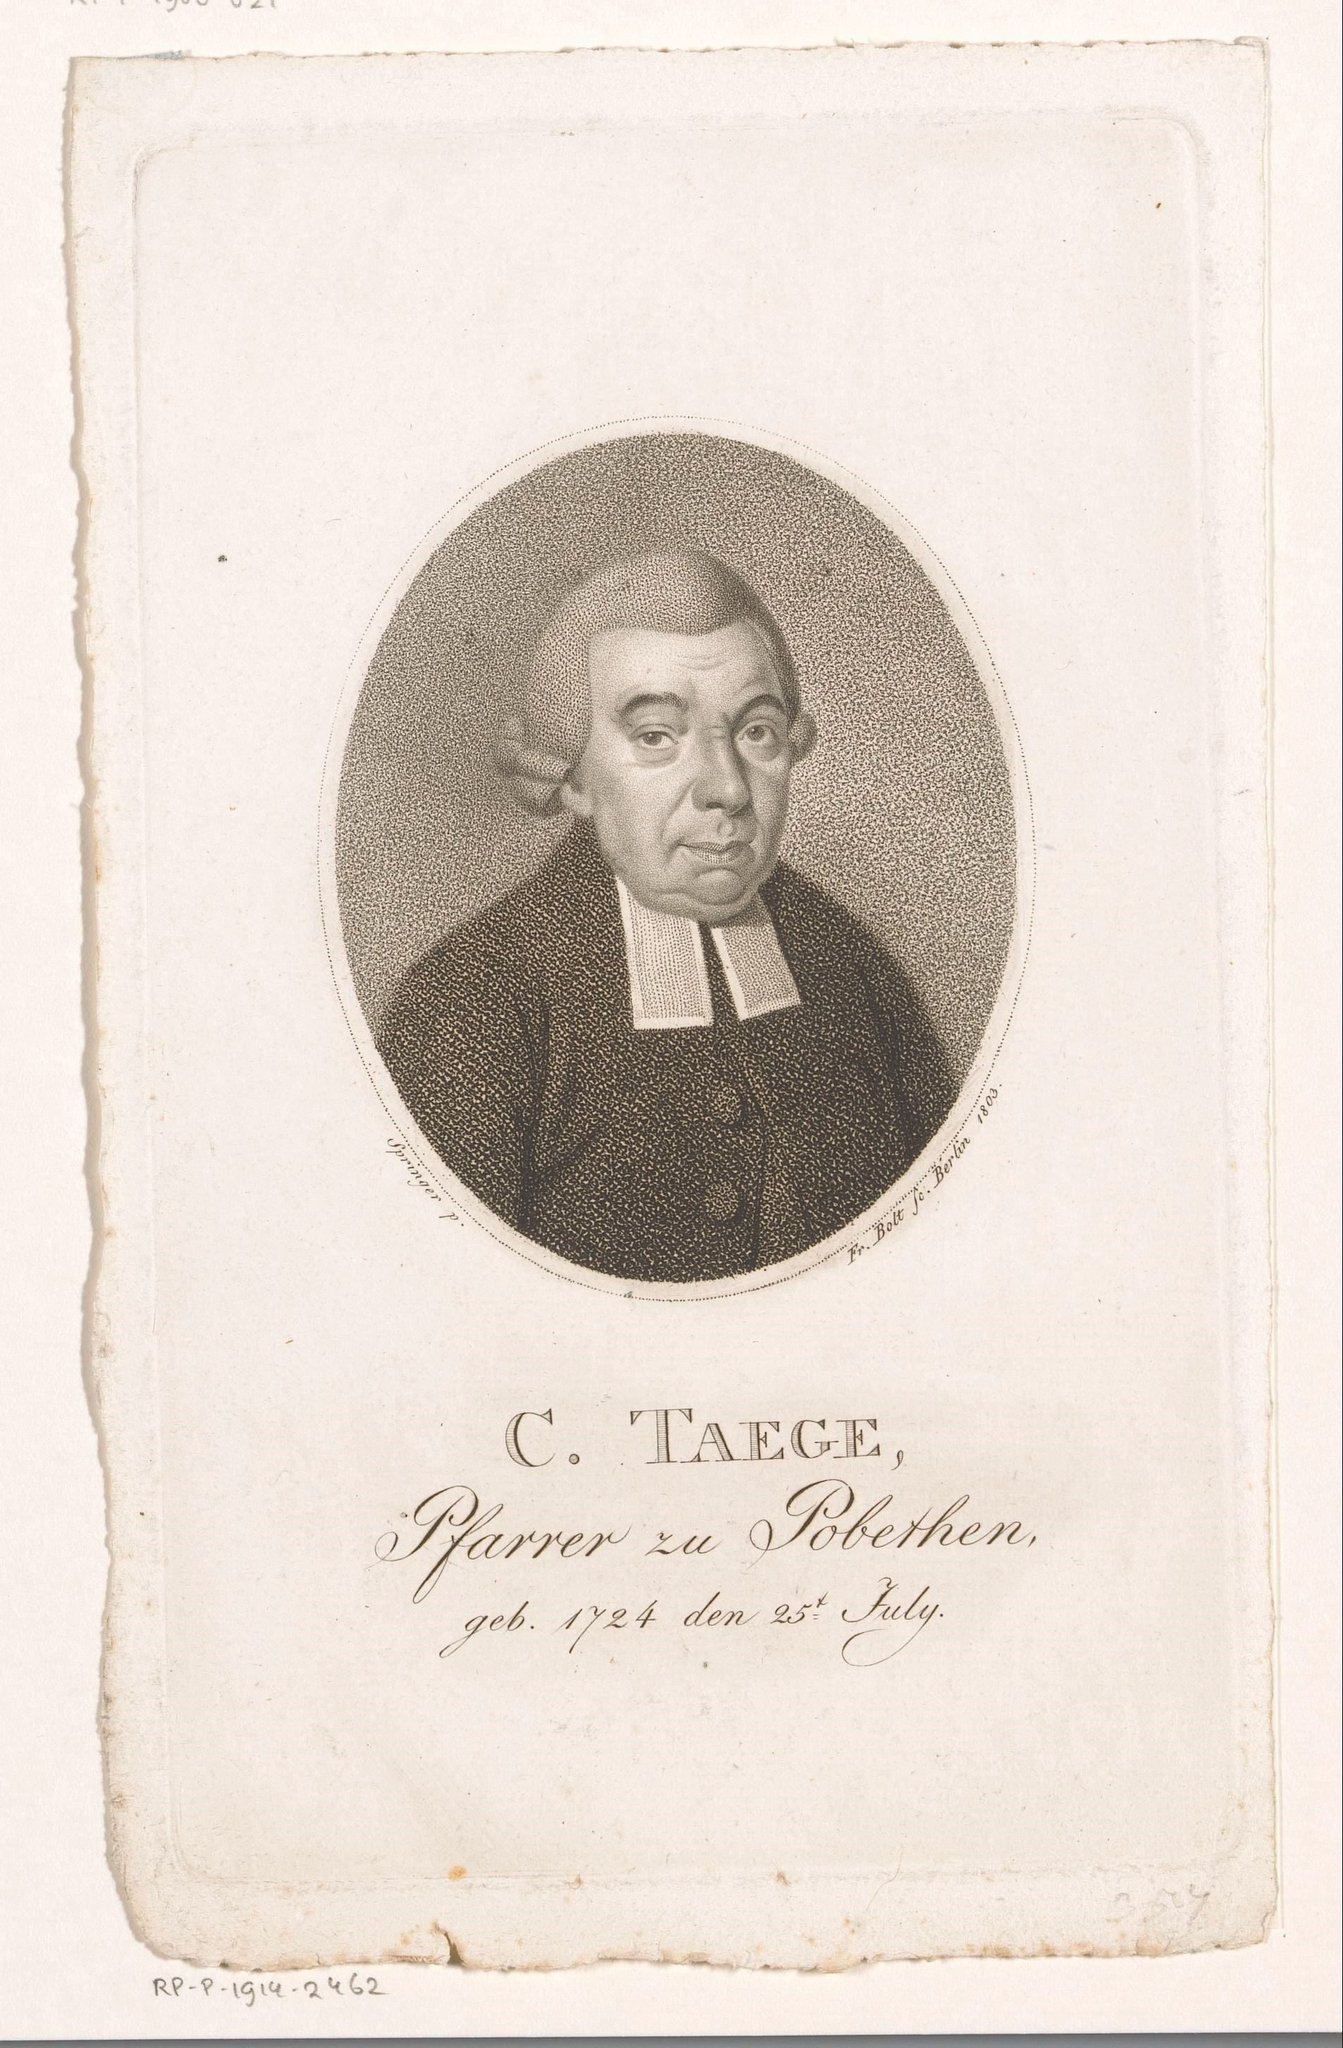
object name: print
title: Portret van Christian Täge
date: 1803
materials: paper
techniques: stippling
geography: berlin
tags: historical persons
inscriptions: collector's mark: Lugt 2228